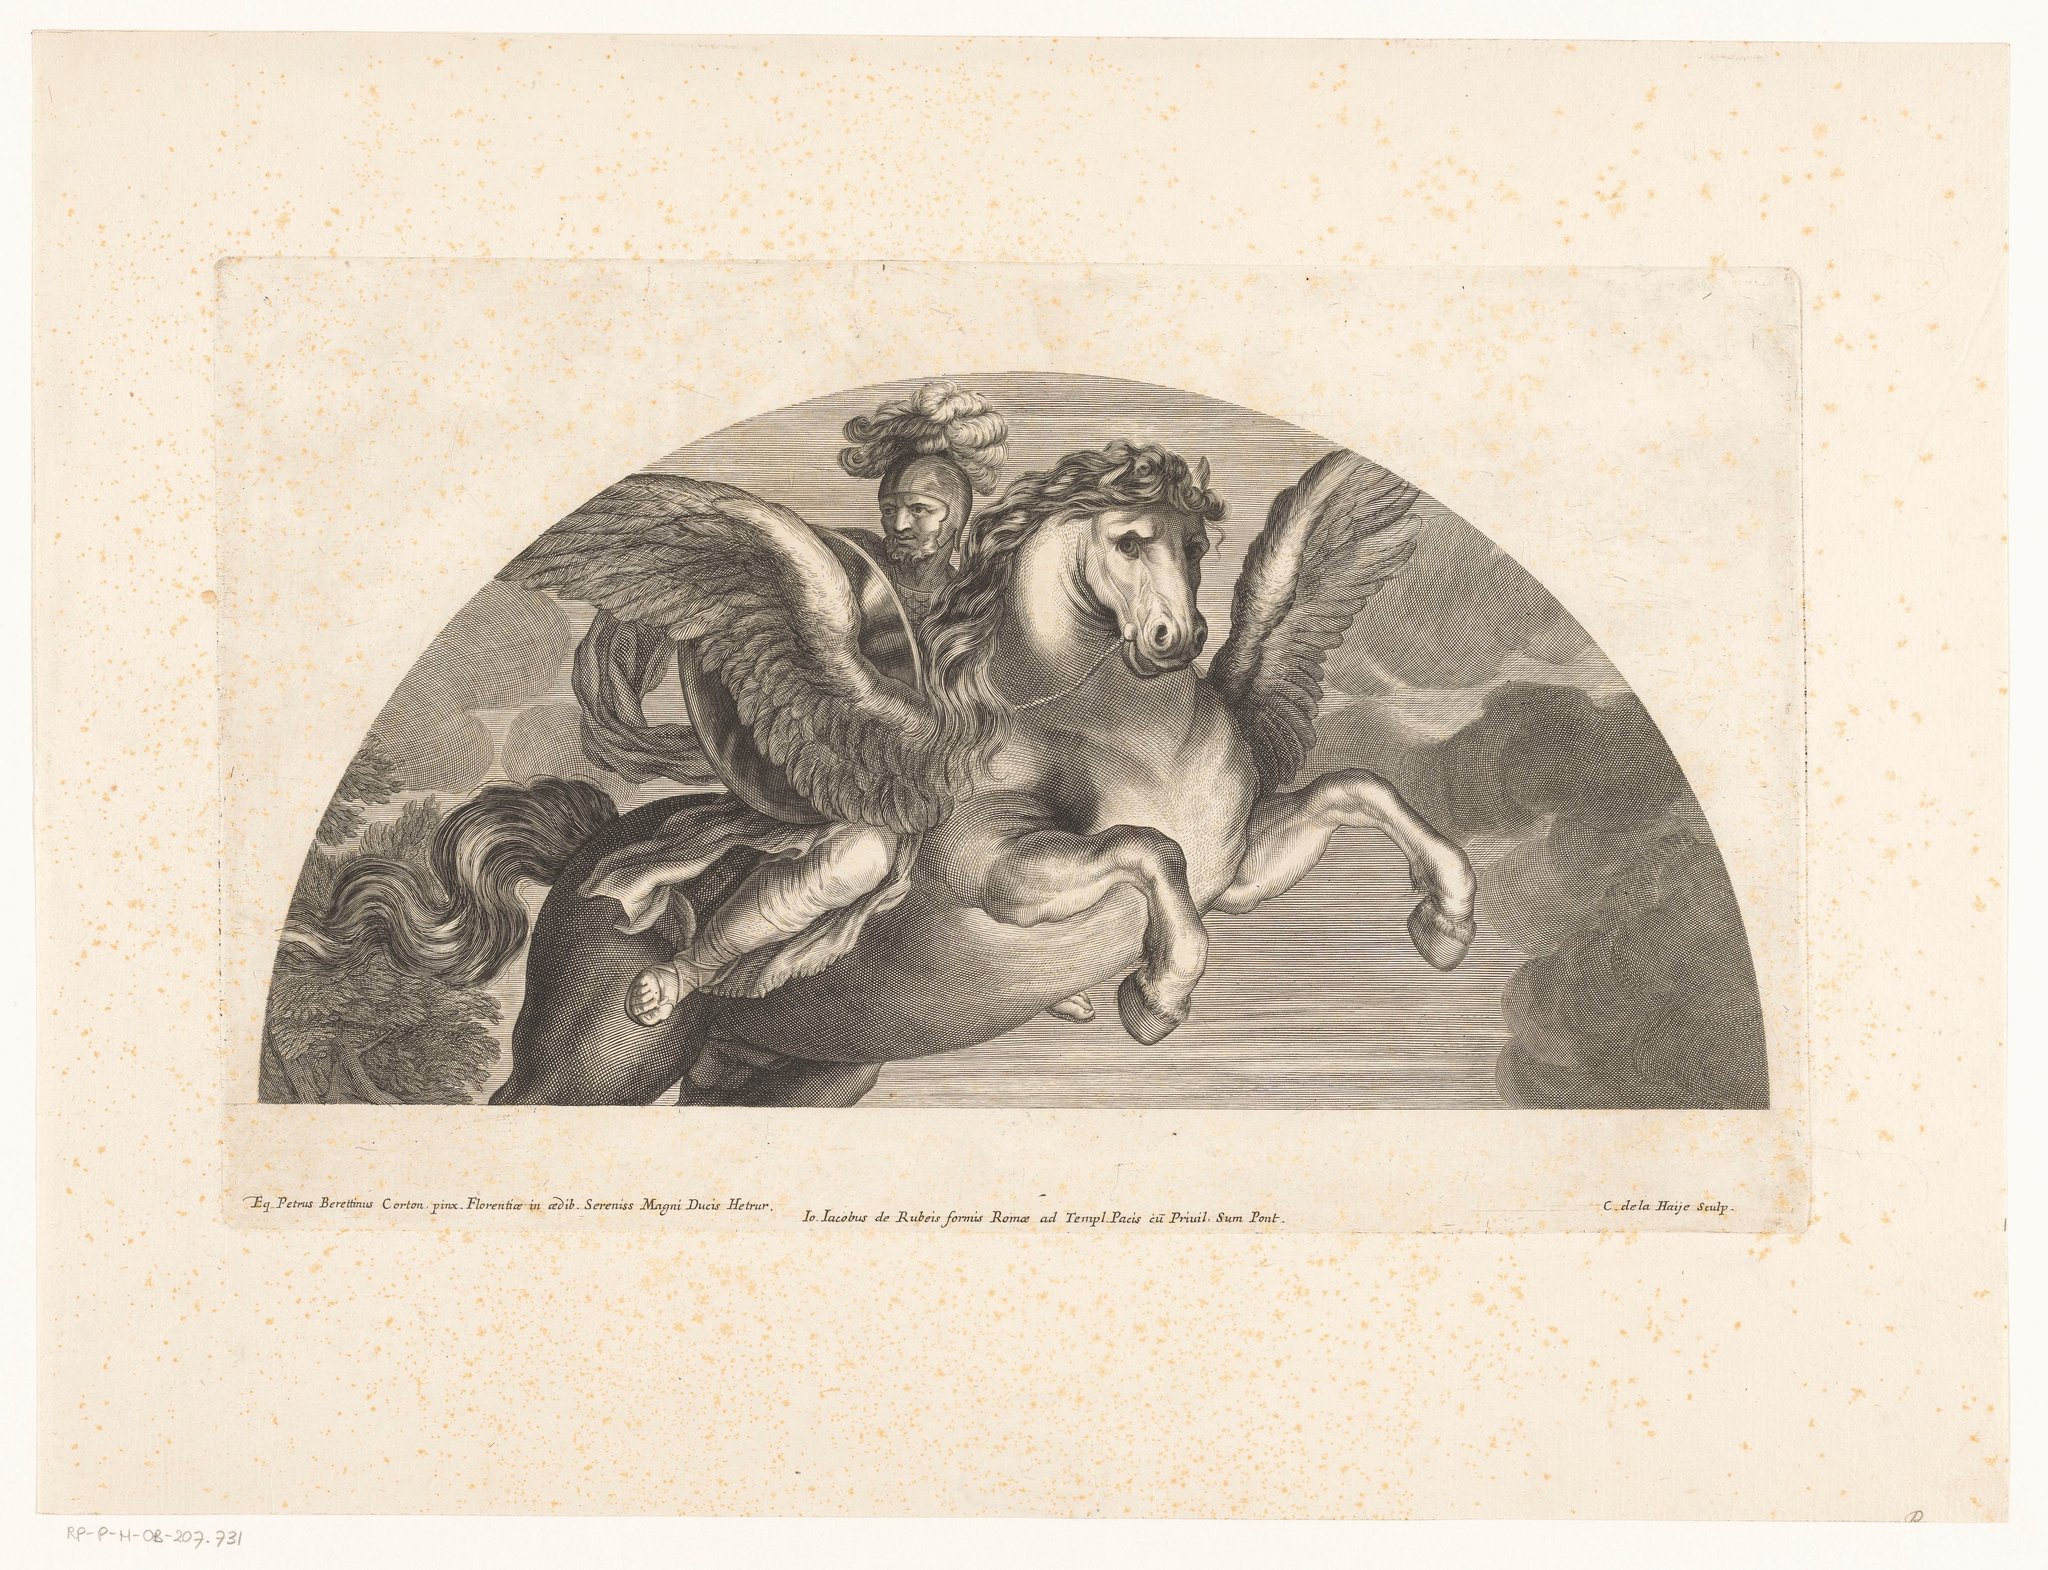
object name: print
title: Bellerophon op Pegasus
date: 1677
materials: paper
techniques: engraving, etching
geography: florence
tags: pegasus, the winged horse, (story of) bellerophon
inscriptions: collector's mark: ‘Hinloopen’, collector's mark: Lugt 11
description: Naar een fresco door Pietro da Cortona in de Sala di Venere in Palazzo Pitti te Florence. De prent maakt deel uit van een reeks van 15 ongenummerde prenten. Deze prent maakte oorspronkelijk deel uit van liber nr. 22 van de Atlas van Rome, uit de collectie Hinloopen. In dit album waren een aantal prentreeksen naar bekende zeventiende eeuwse frescoseries bijeengebonden. In 1709 heeft Schijnvoet op last van de burgemeesters van Amsterdam de collectie herordend. De prenten uit liber 22 kwamen terrecht in Schijnvoet boek nr. 10. De laatst gedateerde reeks in het album is gedateerd 1691. Het album moet dus na deze datum gebonden zijn. De band is in de Rijksakademietijd uit elkaar gehaald. De marges van de prenten zijn bij het opbergen in het Rijksprentenkabinet vaak drastisch afgesneden. Van een aantal series waren de prenten teruggeslagen om in het album te passen. (Zie: Waals, Jan van der. De prentschat van Michiel Hinloopen. 's-Gravenhage: SDU uitgeverij, 1988, pp. 173-174.)